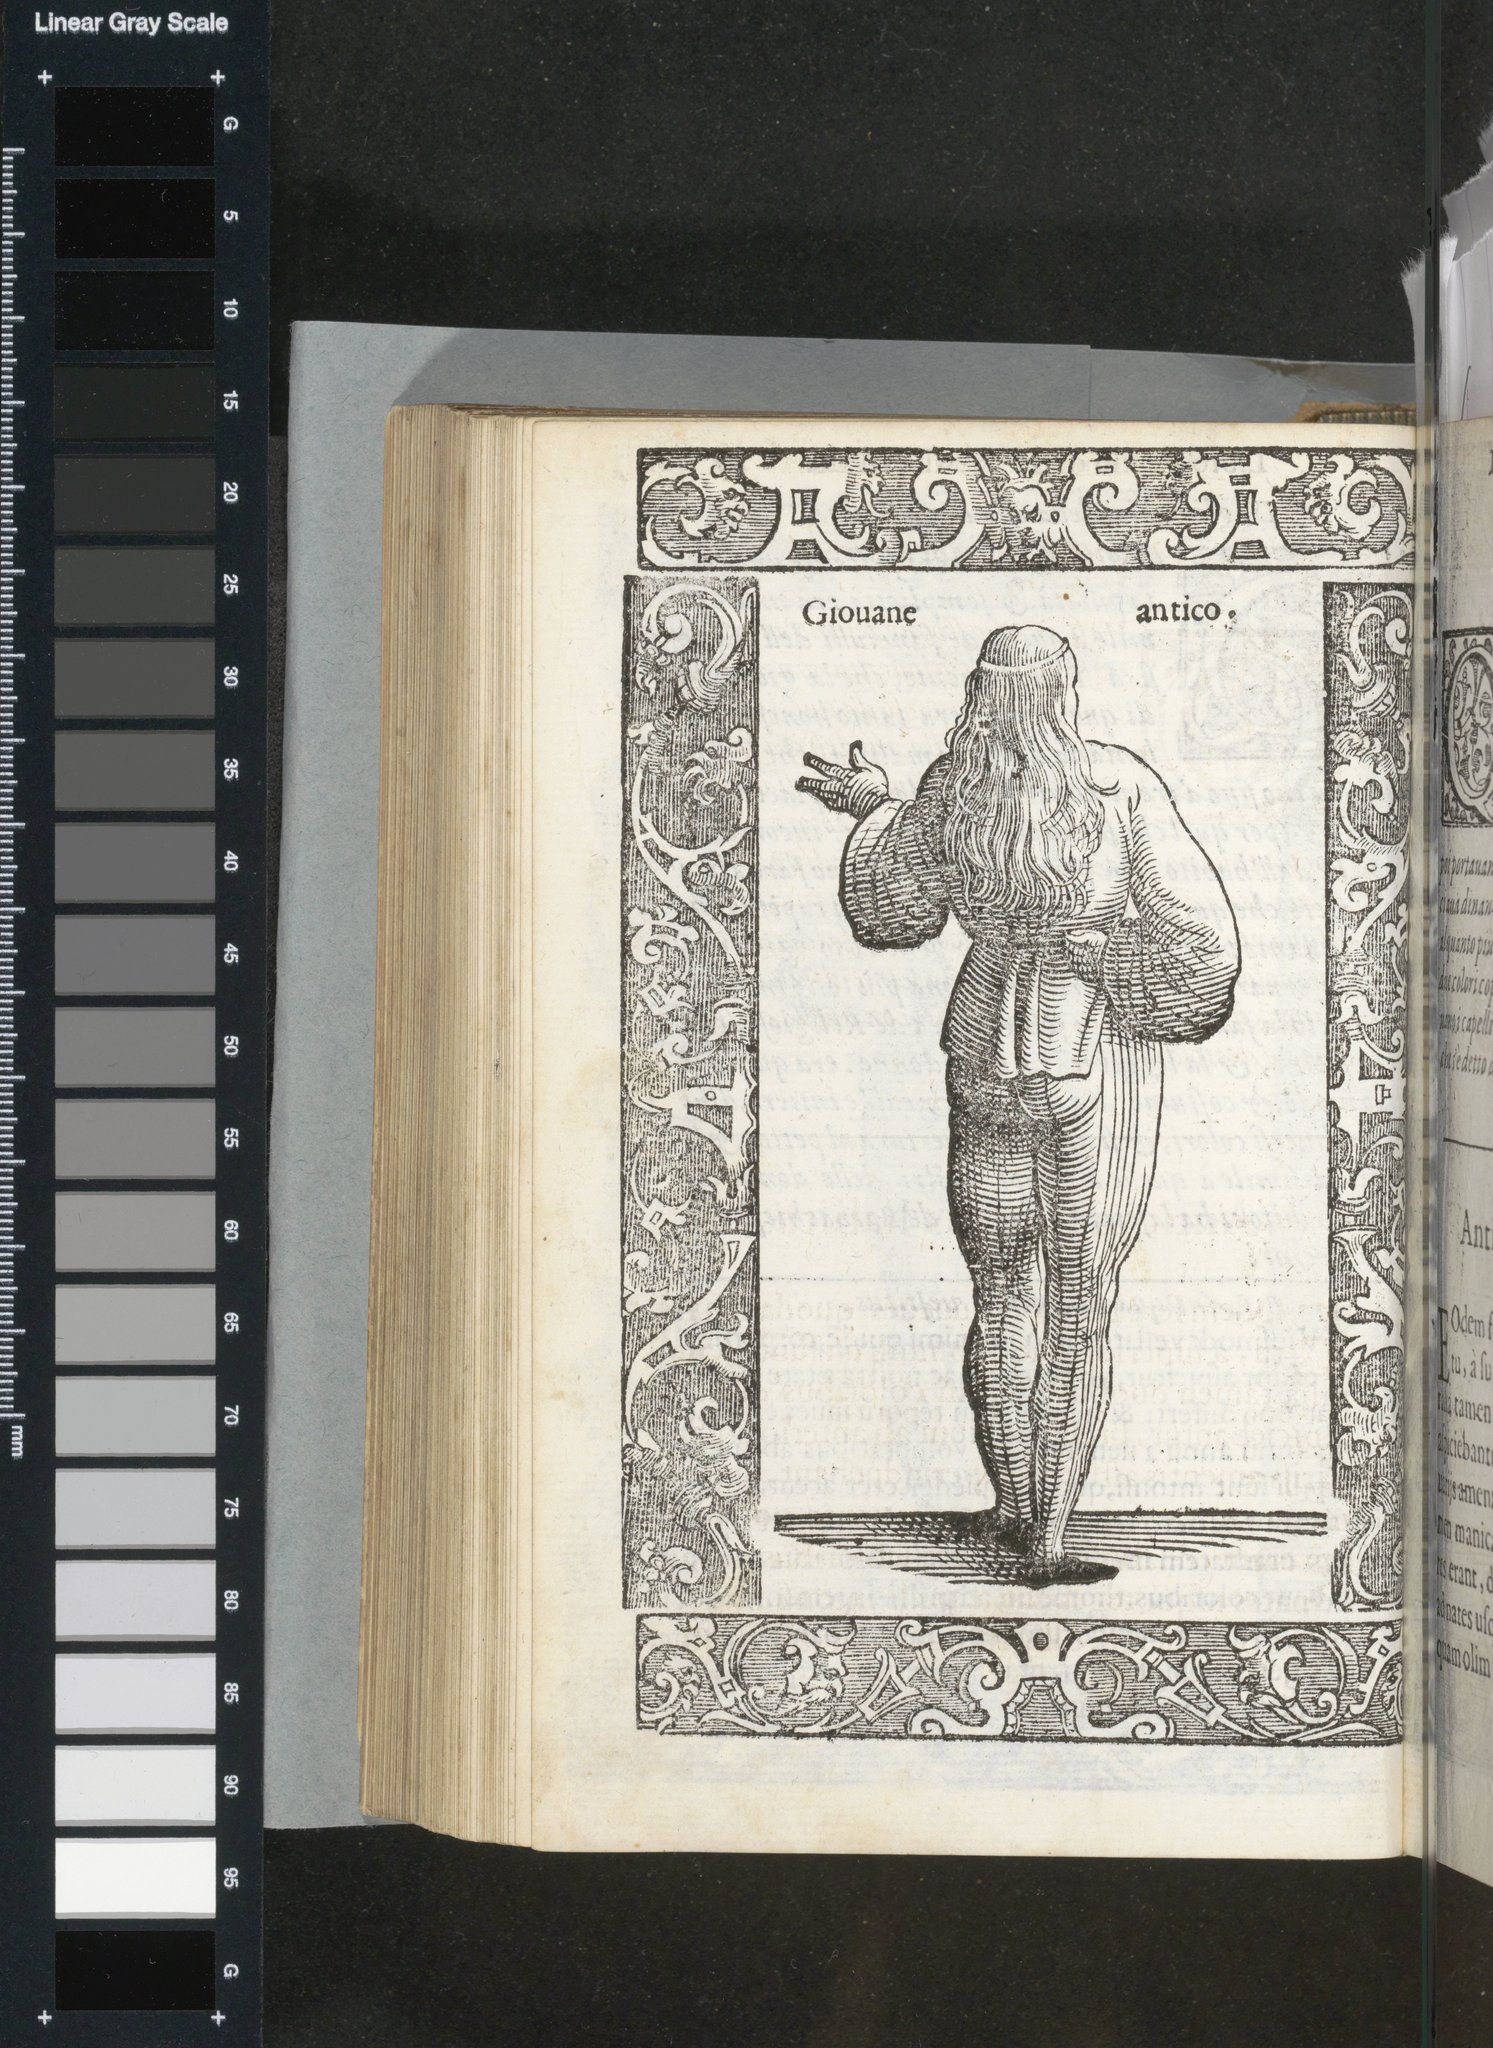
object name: costume print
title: Habiti antichi, et moderni di tutto il mondo..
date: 1598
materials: paper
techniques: woodcut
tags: fashion plates